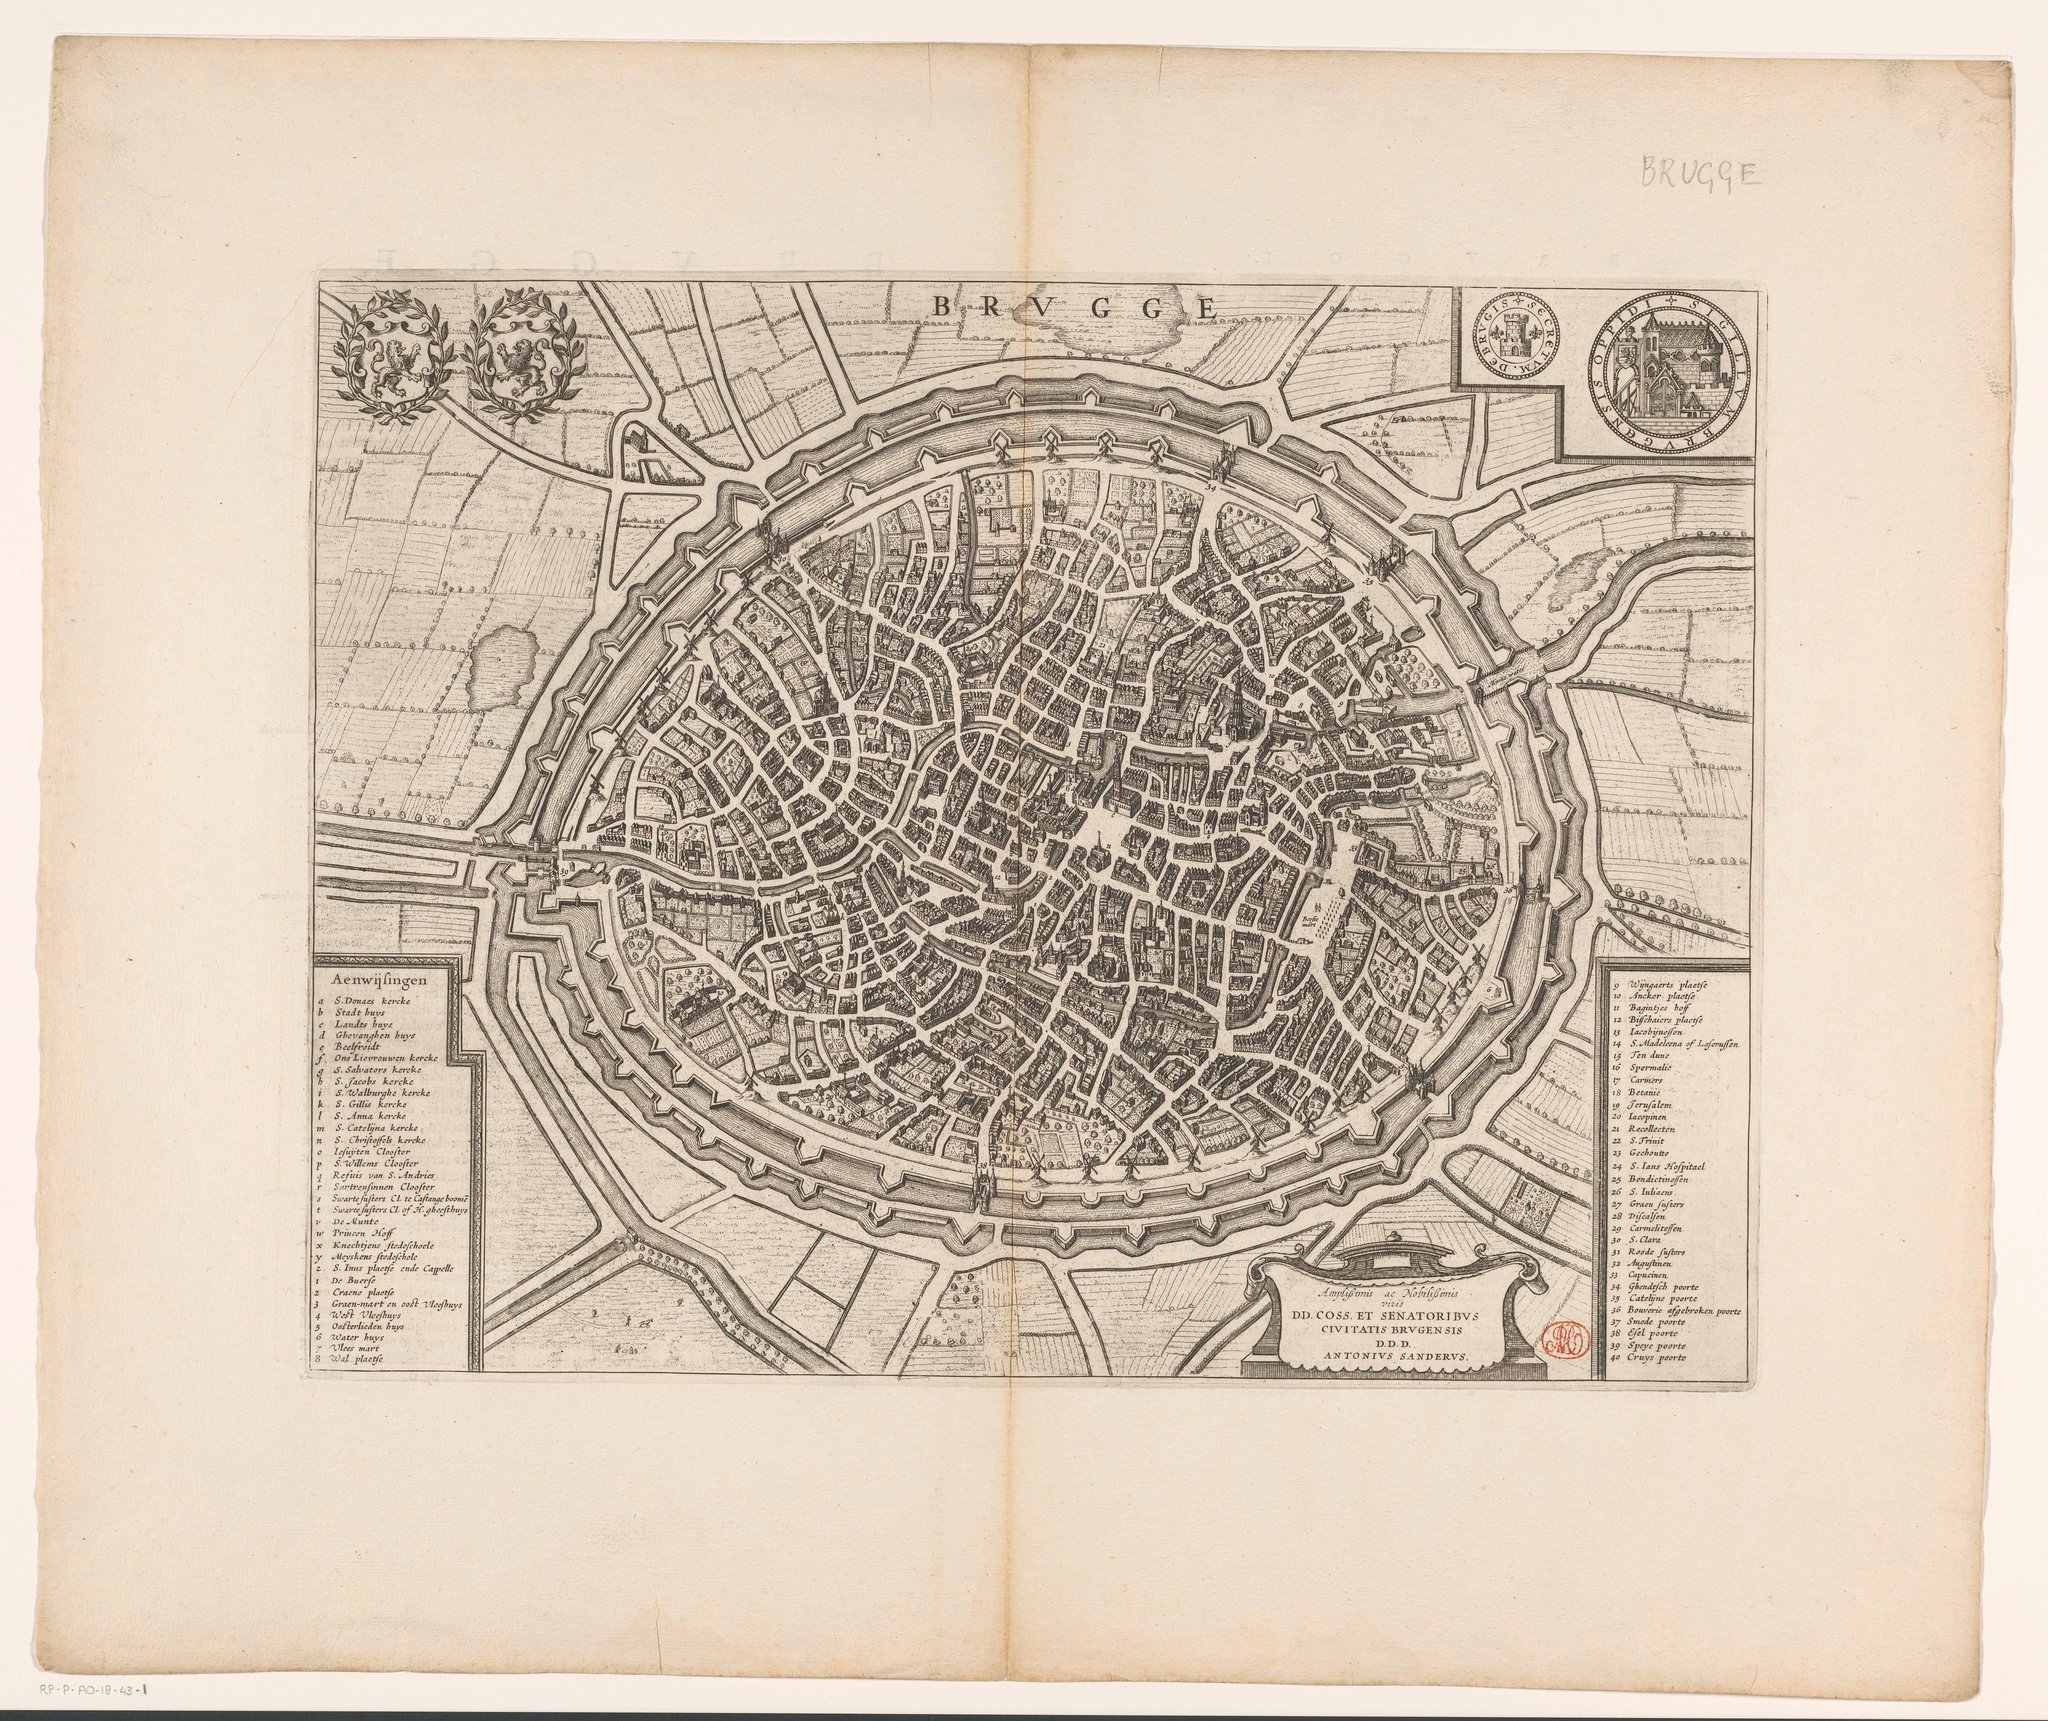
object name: area plan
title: Plattegrond van Brugge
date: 1652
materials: paper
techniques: engraving, etching, letterpress printing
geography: amsterdam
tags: coat of arms (as symbol of the state, etc.) (+ city; municipal), seal (as symbol of the state, etc.) (+ city; municipal), maps of cities, coat of arms (as symbol of the state, etc.) (+ province; provincial), bruges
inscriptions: collector's mark: Lugt 195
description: Plattegrond van Brugge met gebouwen in vogelvluchtperspectief. Boven, in het midden, de titel. Linksonder een kader met legenda A-Z en 1-8. Rechtsonder een kader het vervolg van de legenda, 9-40. Links van dit kader een cartouche met opdracht. Linksboven tweemaal het wapen van het graafschap Vlaanderen, links gespiegeld. Rechtsboven een kader met daarin twee zegels van Brugge. Op verso Nederlandse tekst.